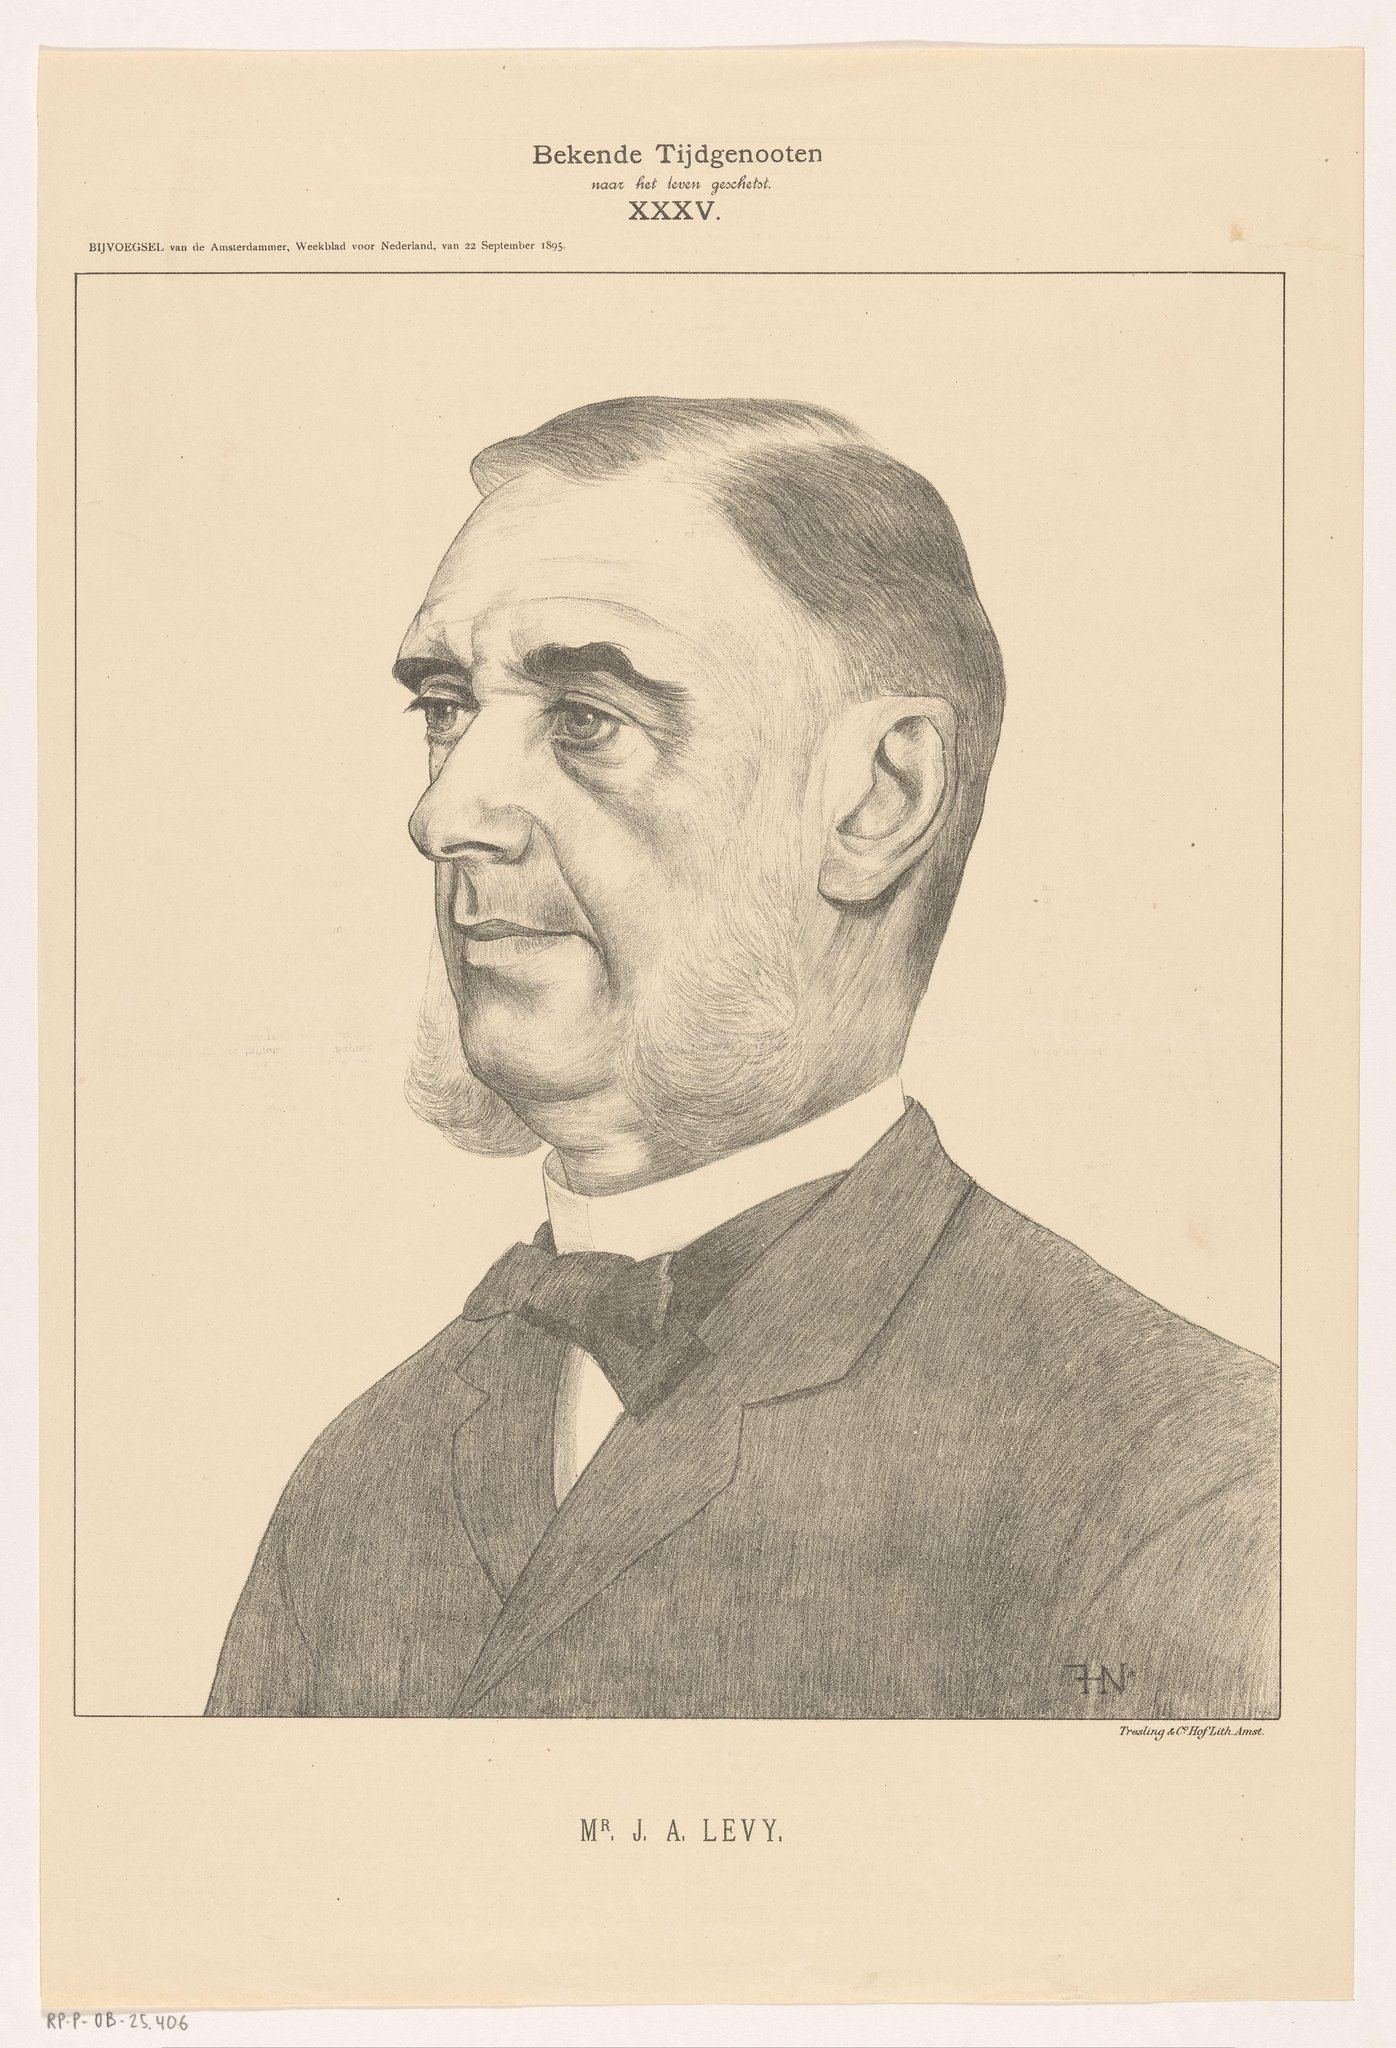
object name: print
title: Bekende tijdgenooten naar het leven geschetst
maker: ferdinand hart nibbrig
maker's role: draughtsman, painter, print maker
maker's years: 1866-1915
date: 1895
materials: paper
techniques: lithograph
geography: amsterdam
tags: amsterdam, politician, e.g. party leader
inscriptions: collector's mark: Lugt 2228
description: Verschenen in het bijvoegsel van 'De Amsterdammer, Weekblad voor Nederland' van 22 september 1895.